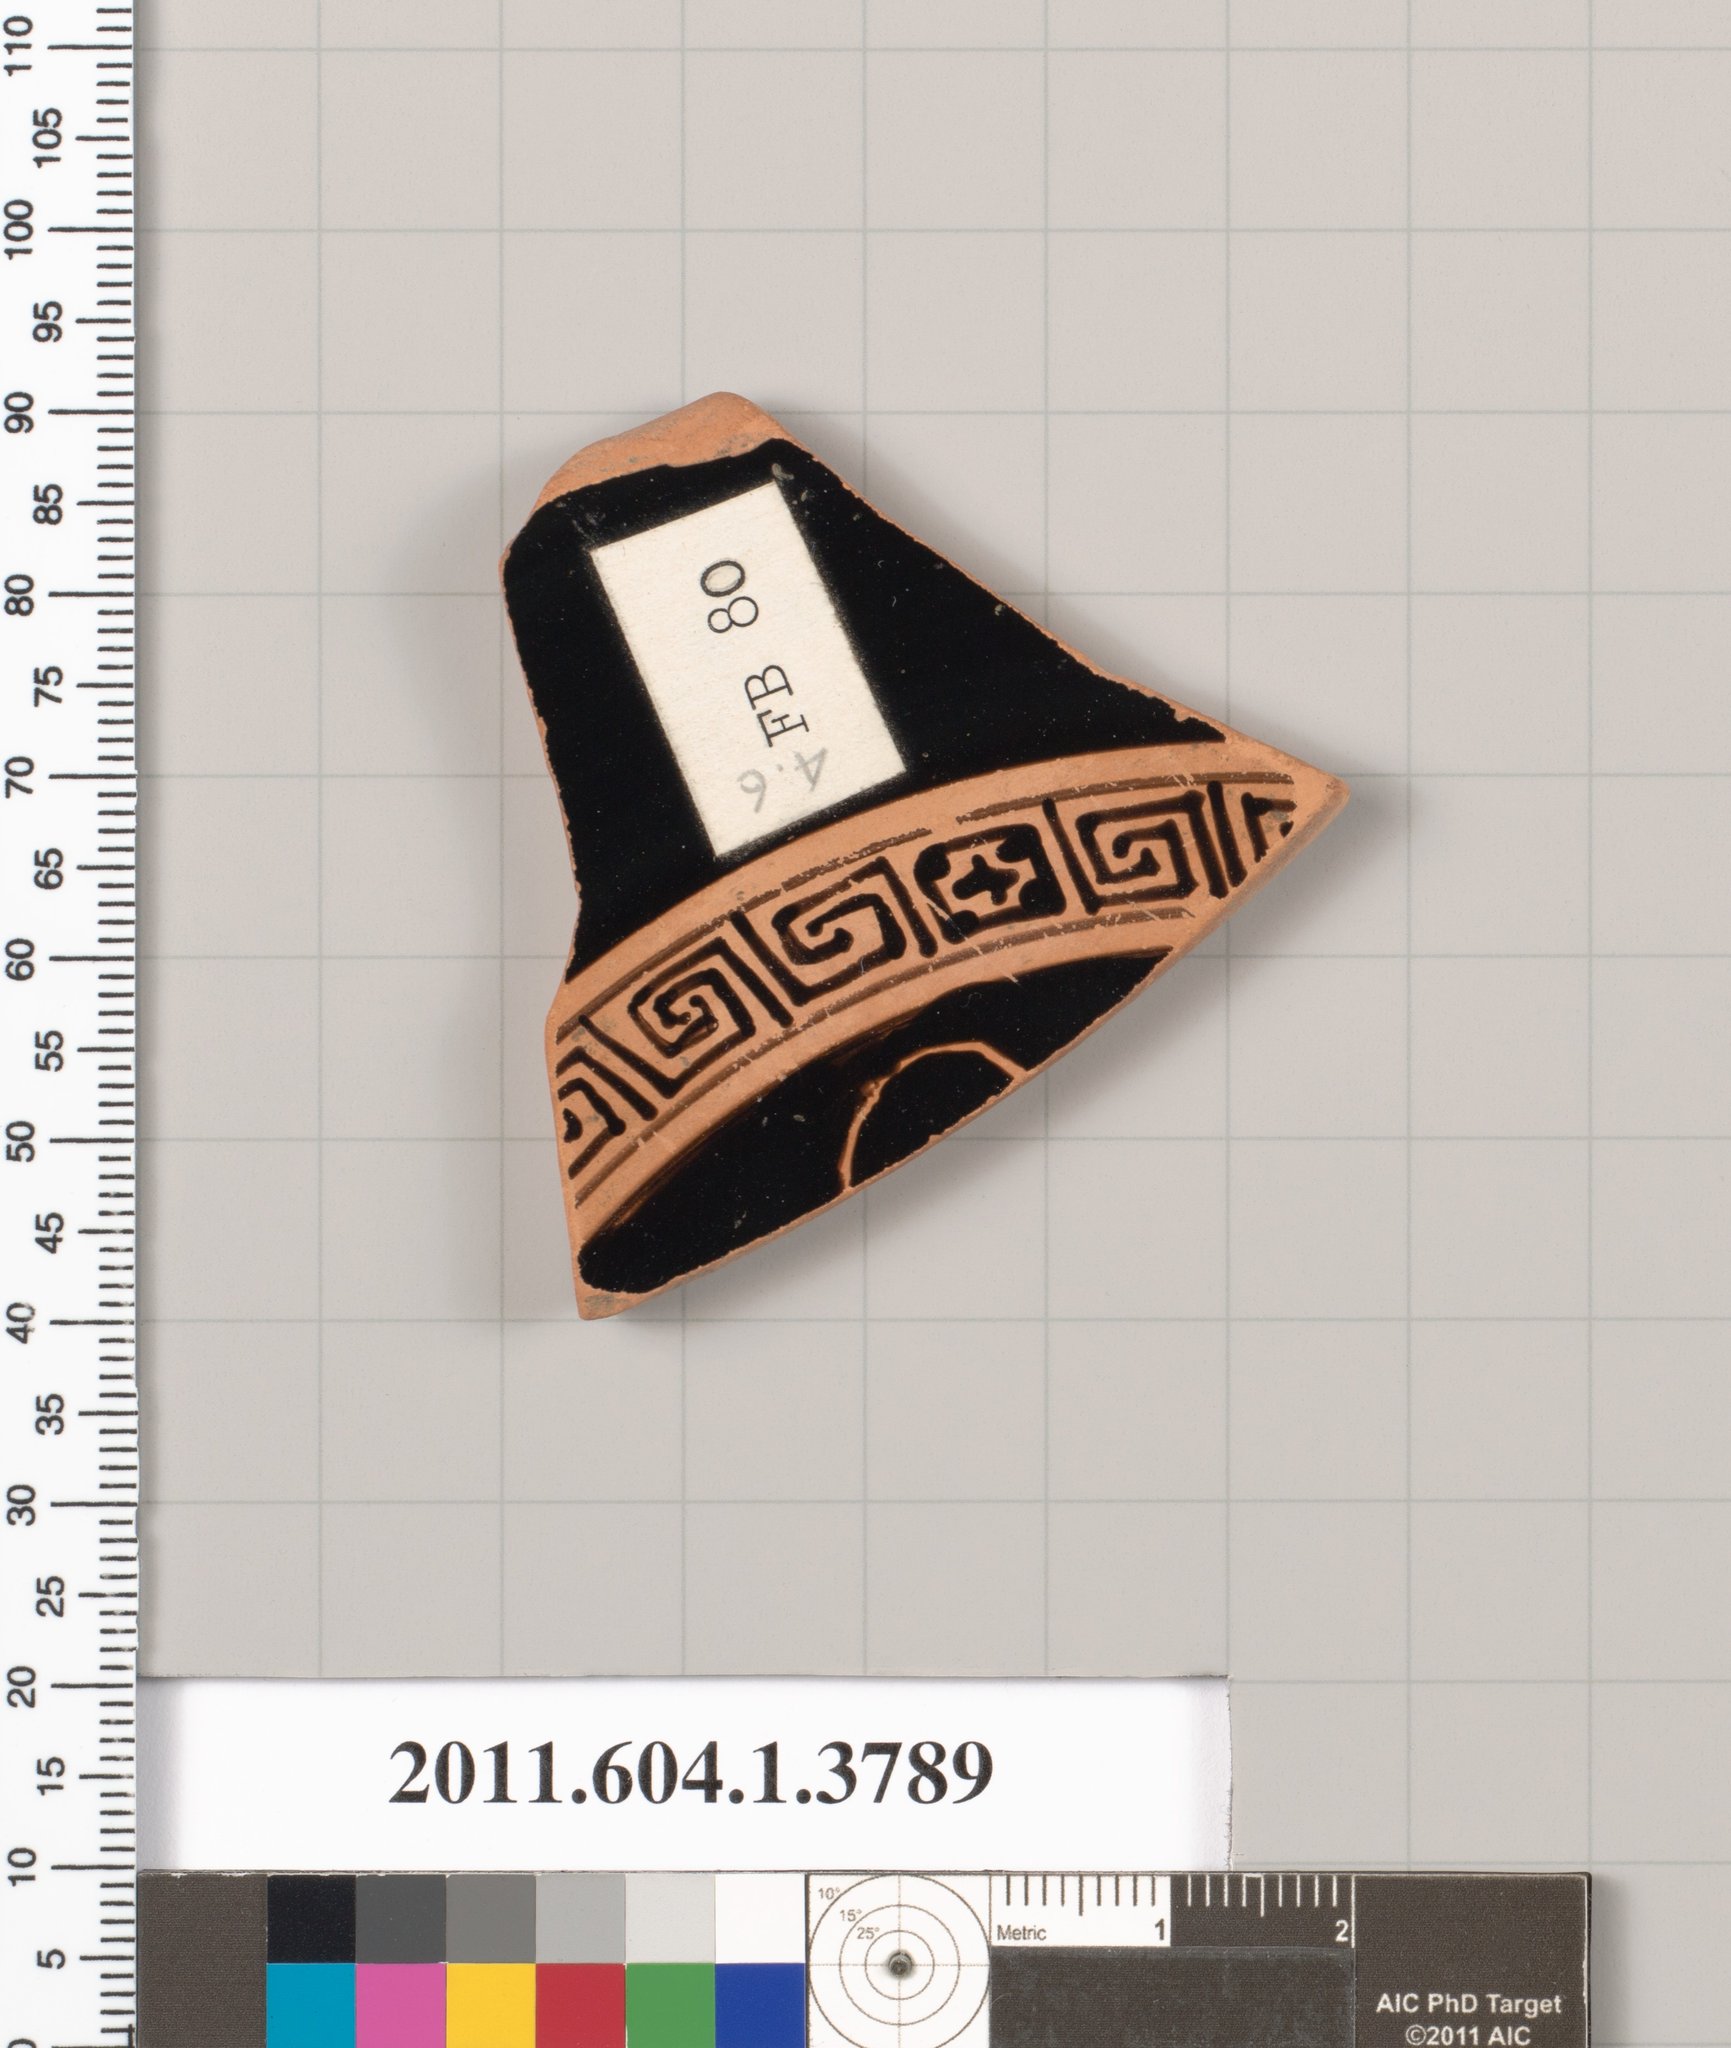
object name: kylix fragment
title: Terracotta fragment of a kylix (drinking cup)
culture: greek, attic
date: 475-451 BCE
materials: terracotta